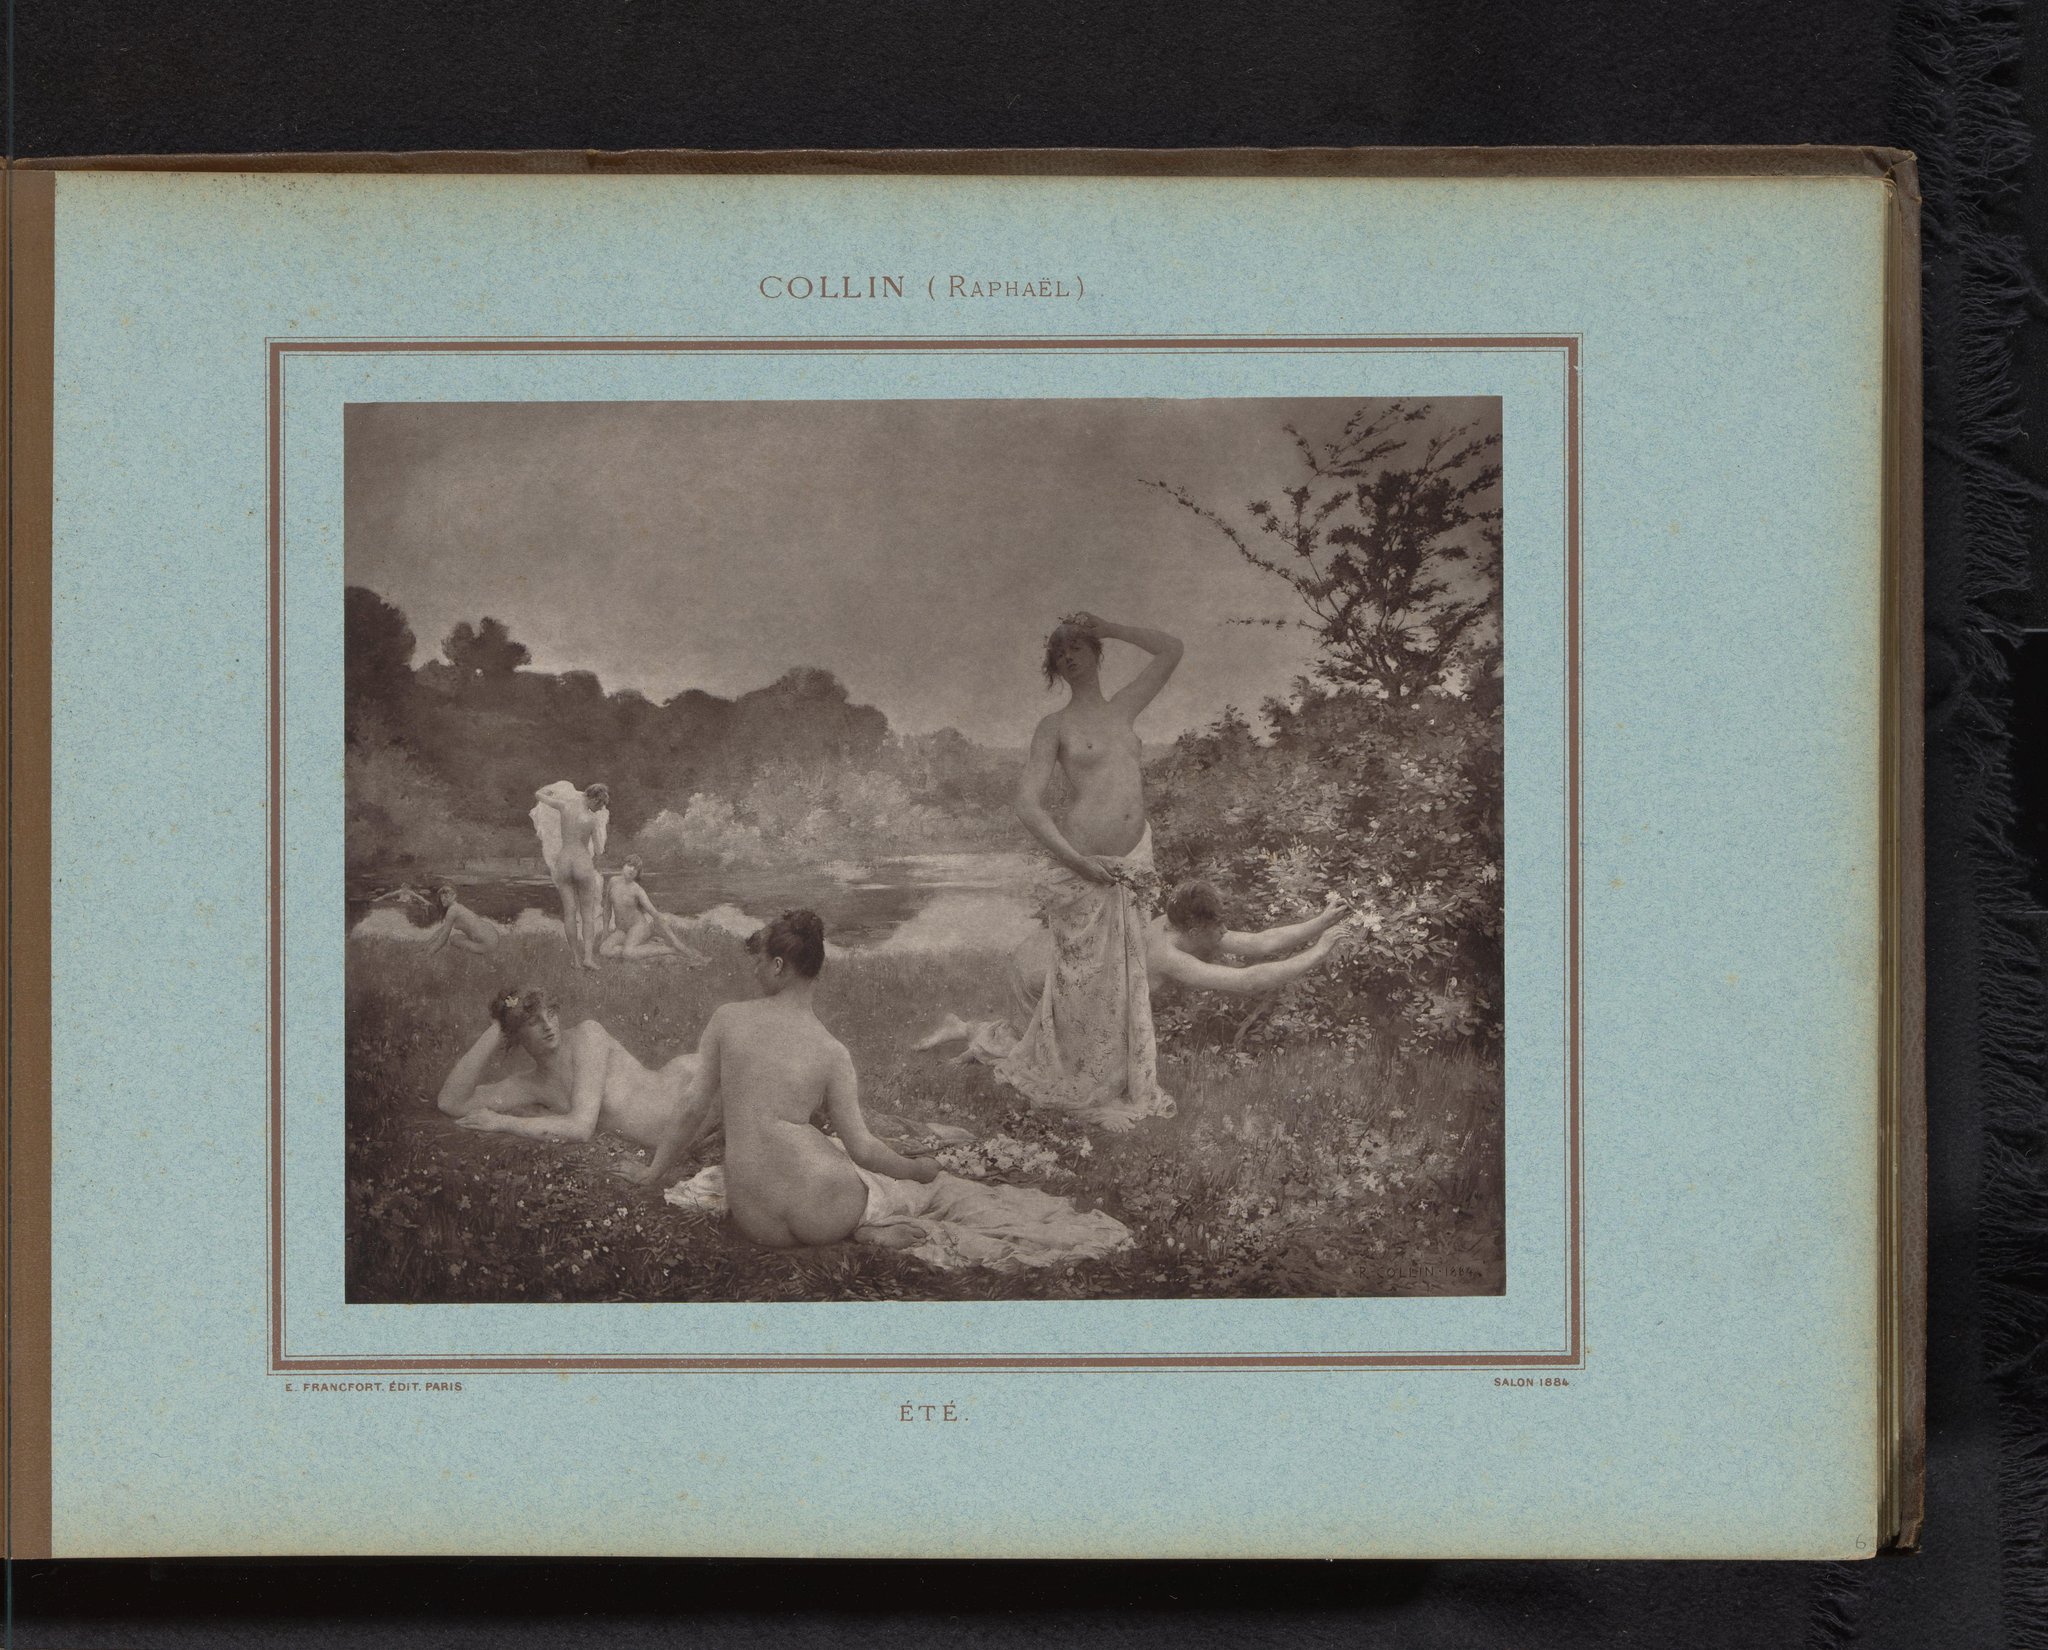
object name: page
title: Reproductie van een schilderij van ontblote vrouwen aan de oever van een waterpartij, door Raphaël Collin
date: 1884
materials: paper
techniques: woodburytype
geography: paris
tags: woman (showing herself) undressed, quasi-nude, river bank (+ landscape with figures, staffage)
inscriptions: inscription: ‘SALON 1884.’, name: ‘COLLIN (Raphaël)’